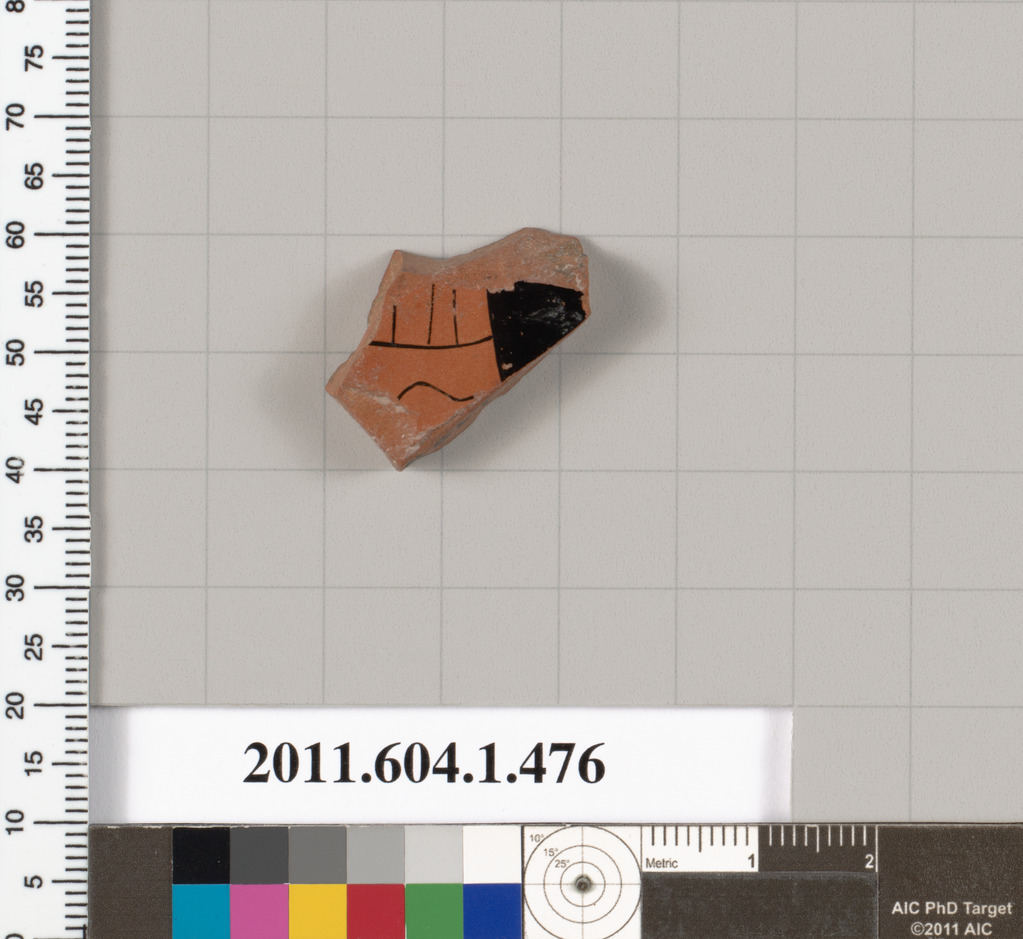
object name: kylix fragment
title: Terracotta fragment of a kylix (drinking cup)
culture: greek, attic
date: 490-480 BCE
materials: terracotta